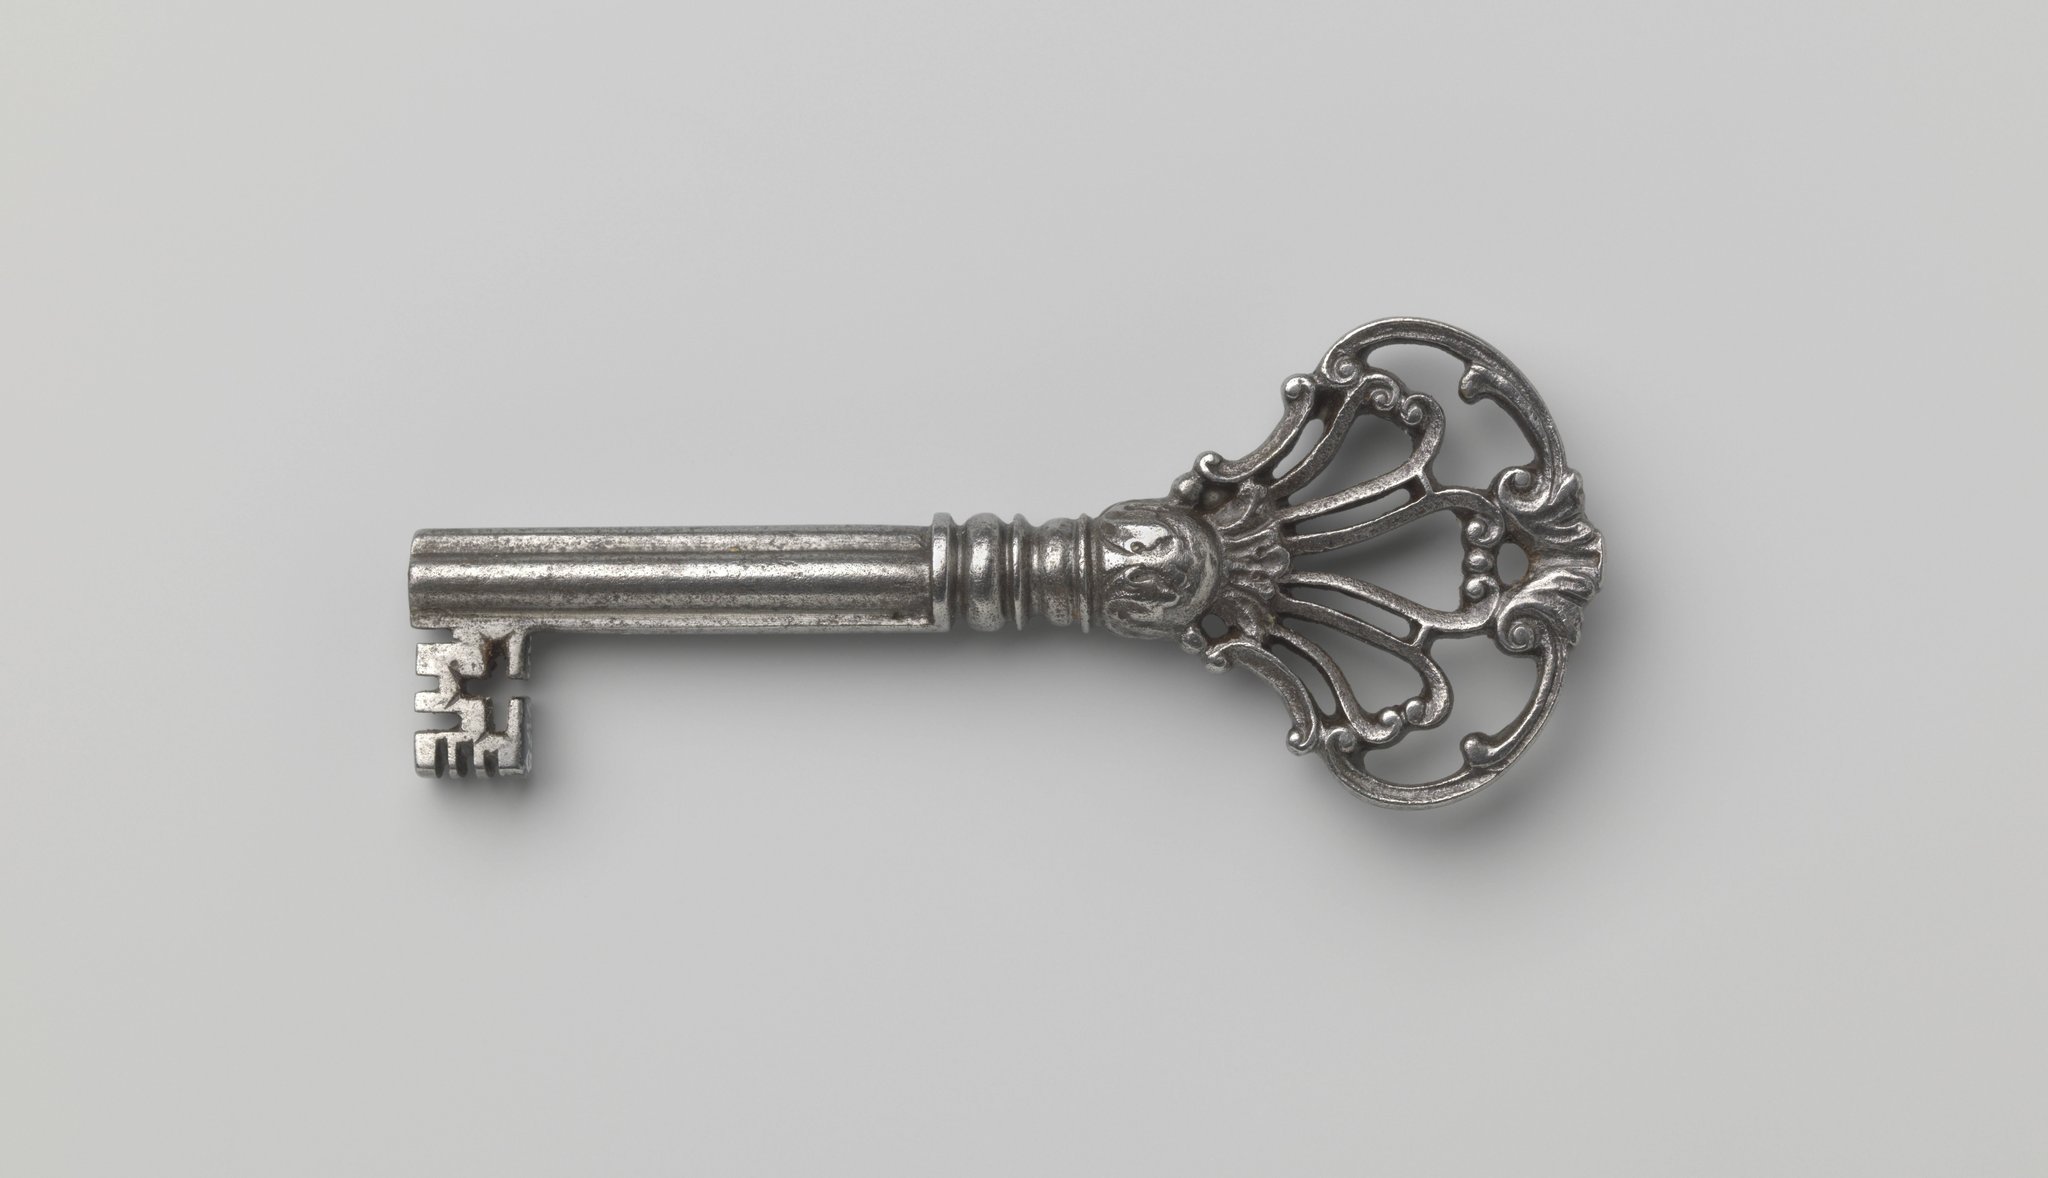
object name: key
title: Sleutel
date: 1725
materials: iron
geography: france